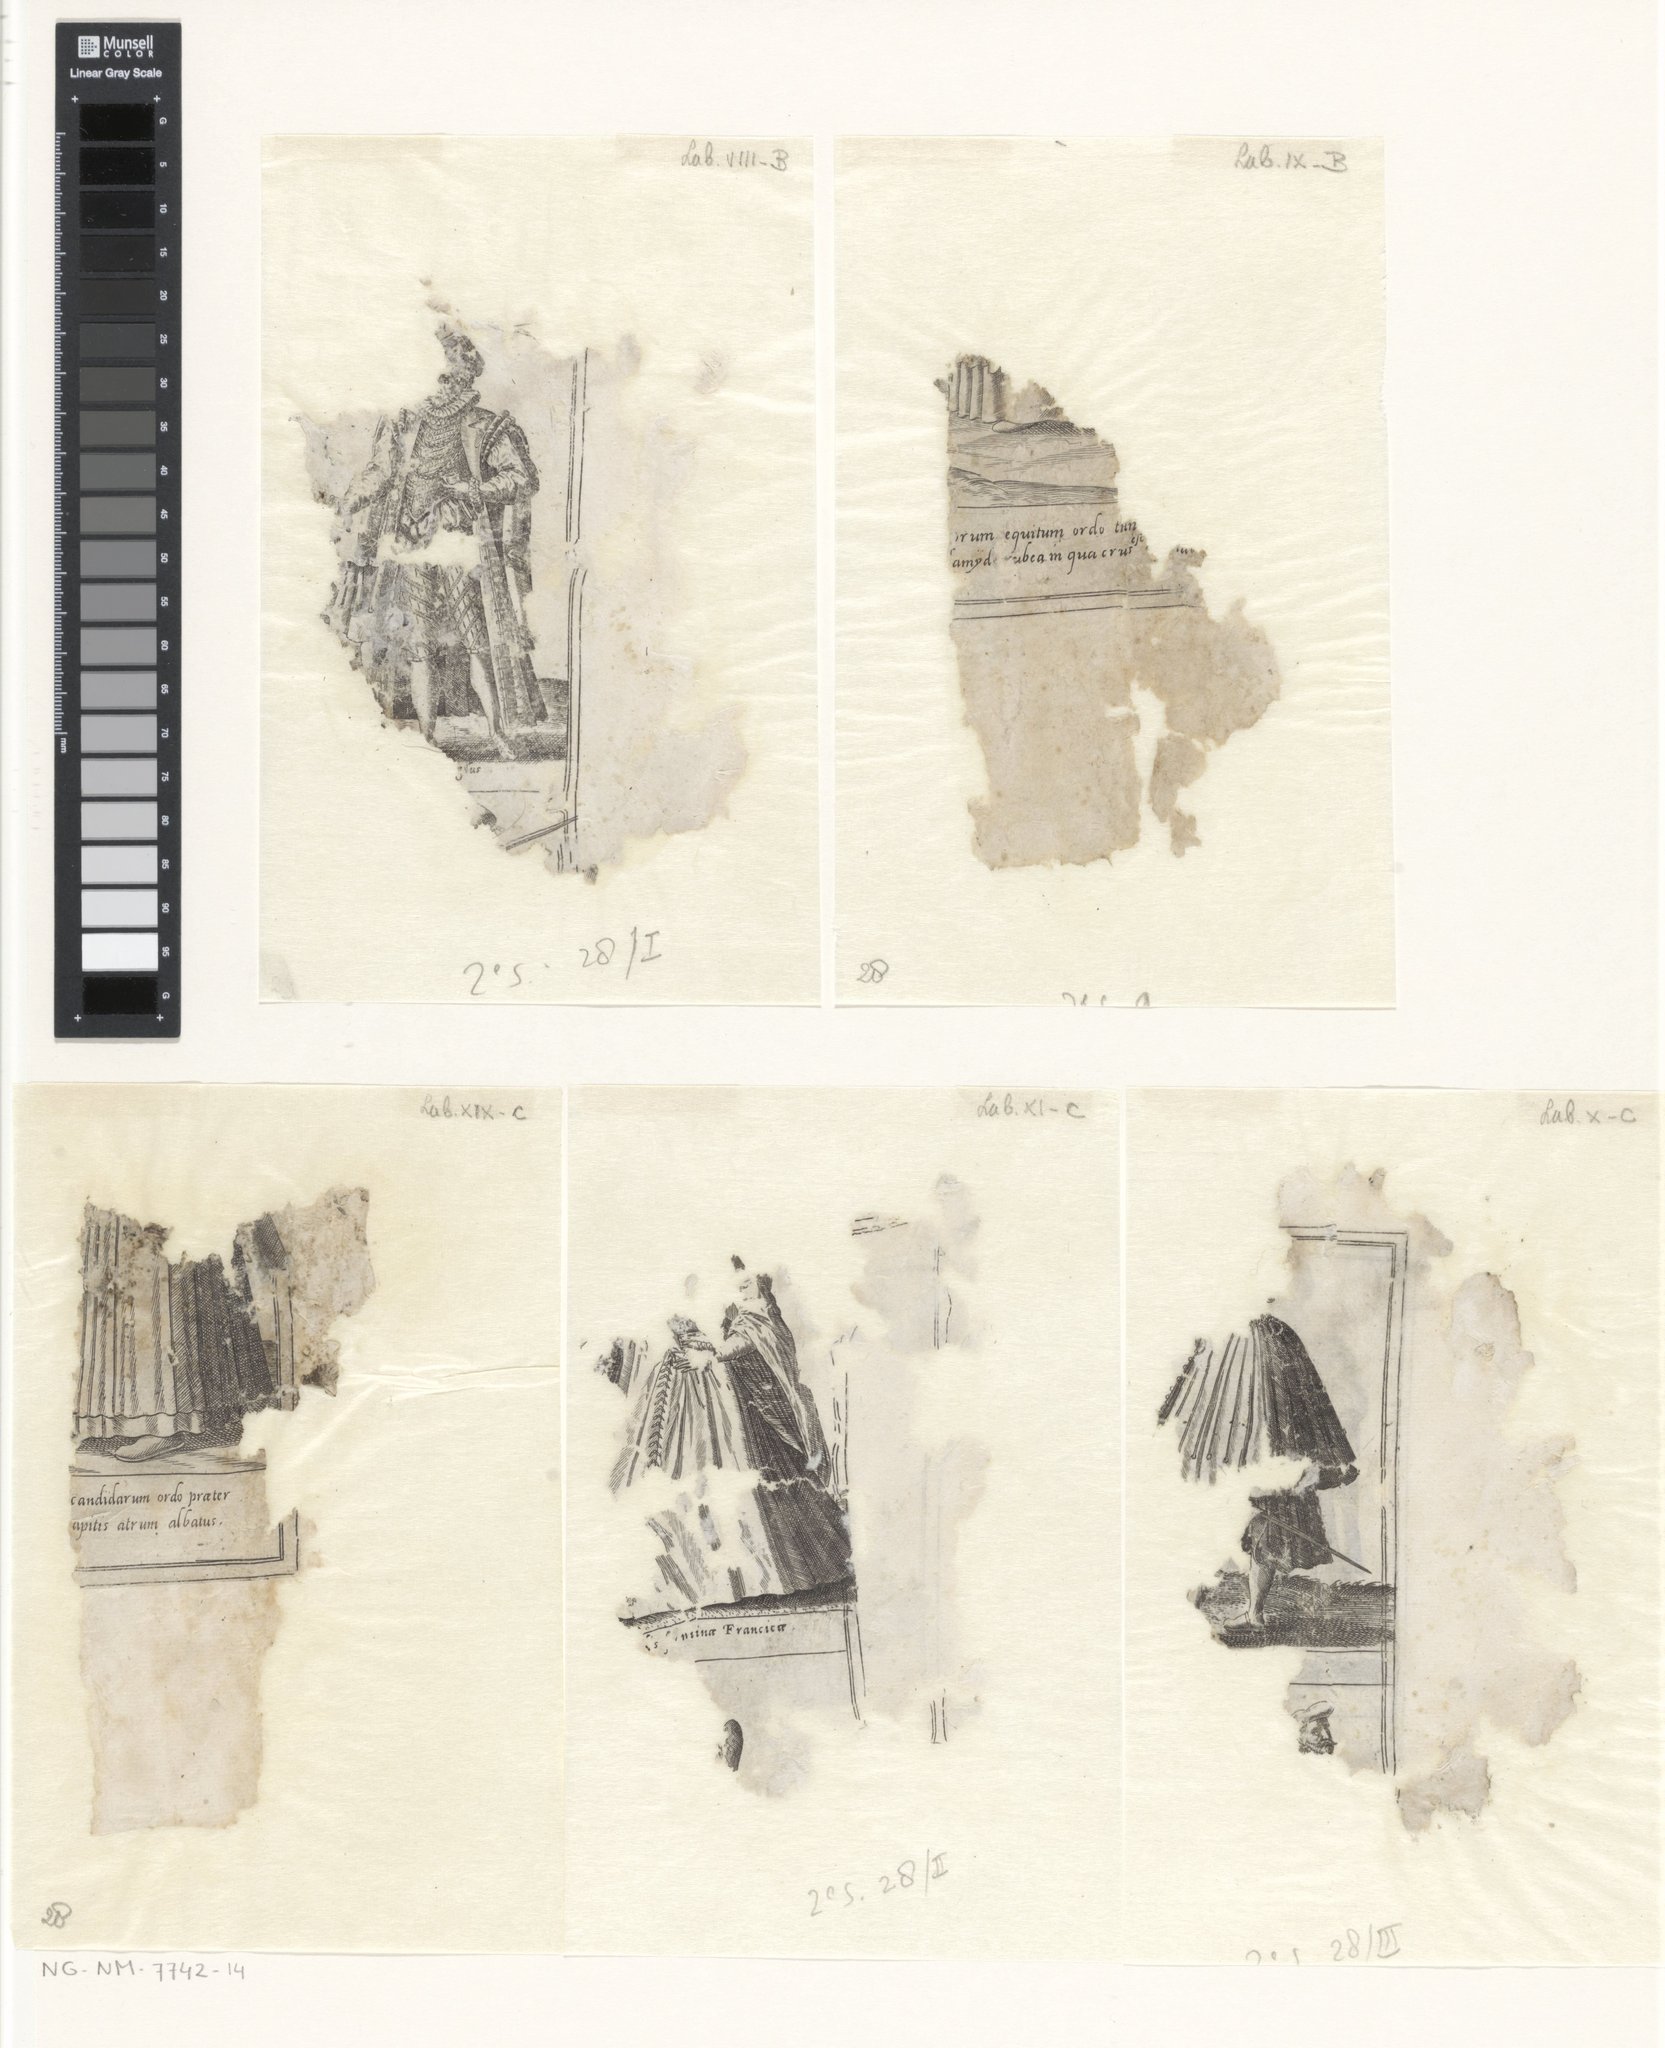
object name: print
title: Fragmenten van prenten met wereldlijke en geestelijke klederdrachten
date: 1581-1596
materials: paper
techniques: engraving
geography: cologne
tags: clothes, costume (+ women's clothes), clothes, costume (+ men's clothes)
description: De prenten in de Nova Zembla collectie zijn tijdens een expeditie van Willem Barendsz en Jacob van Heemskerk in 1596-1597 noodgedwongen in het winterkamp, het ‘Behouden Huis’, op het eiland achtergelaten. De prenten waren in één of meerdere stapels als handelswaar meegenomen vanuit Amsterdam. Bijna drie eeuwen later, in 1871, keerde de Noor Elling Carlsen terug naar Nova Zembla en vond daar de restanten van het ‘Behouden Huis, inclusief een groot deel van de inventaris. Een deel van de prenten, in de vorm van aaneengekoekte kluiten, werd toen ook teruggevonden. De papierkluiten waren soms op meerdere plekken gebroken. Tussen 1975-1979 zijn de prenten van elkaar gescheiden. Dit leverde in totaal ca. 1000 fragmenten van ca. 400 afdrukken van ca. 150 verschillende prenten op. Voor zover mogelijk zijn de fragmenten samengevoegd en zijn de prenten gereconstrueerd.